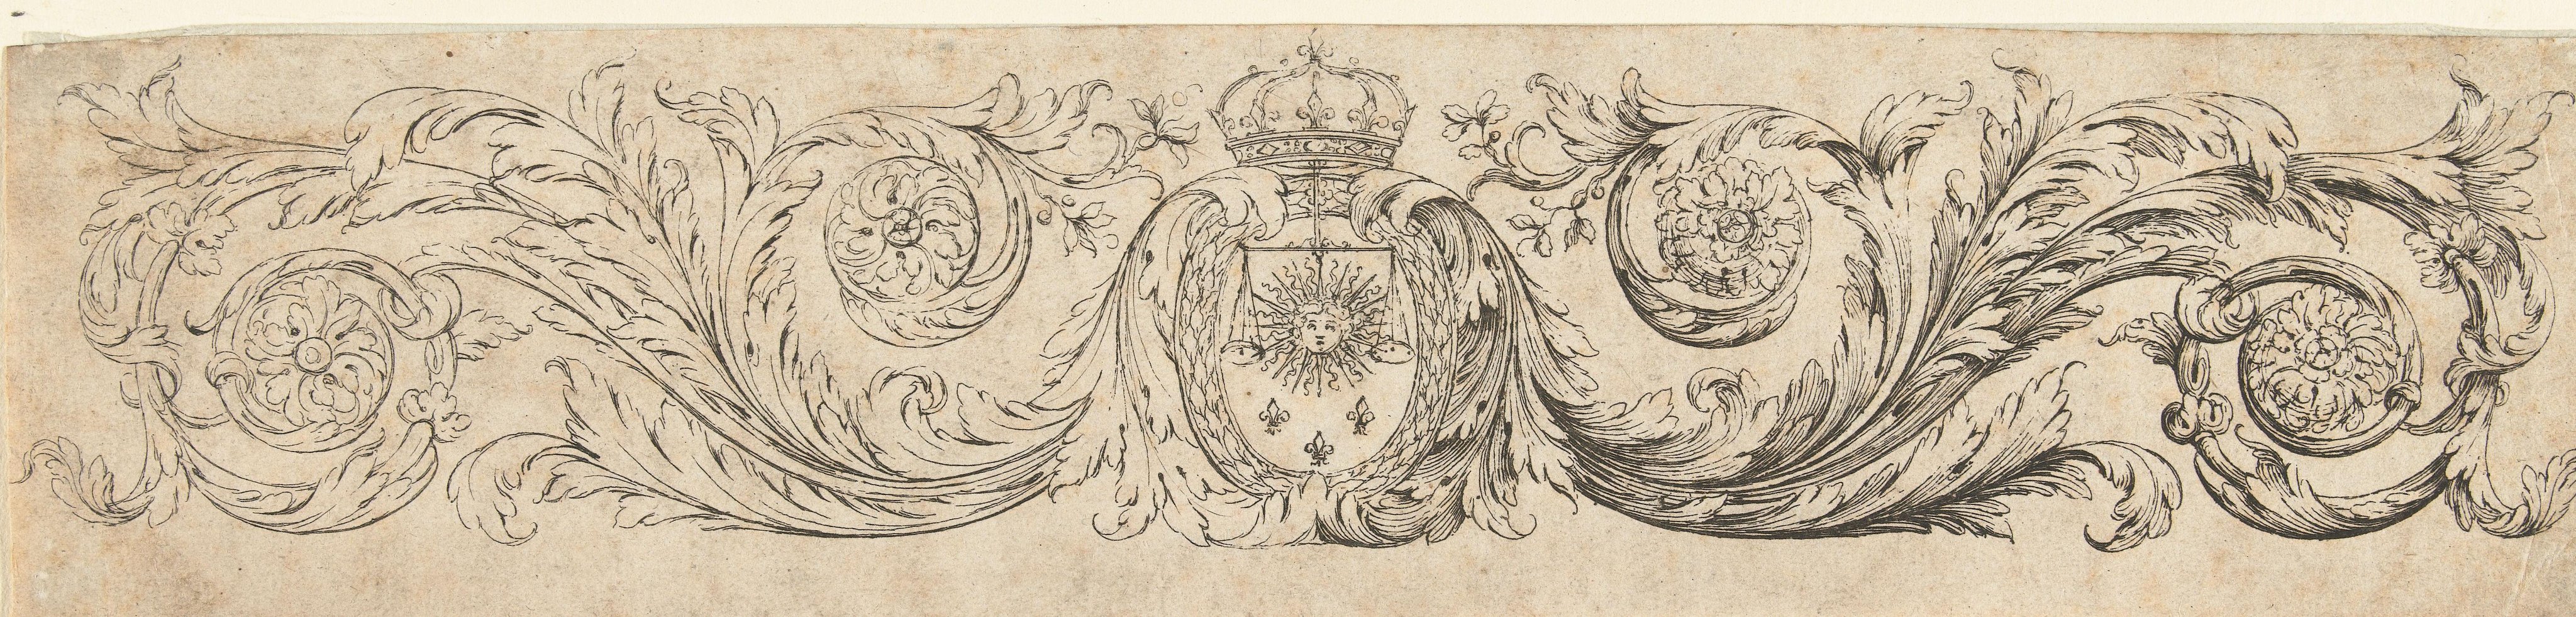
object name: print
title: Twee bladranken met rozetten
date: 1670-1693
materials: paper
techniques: etching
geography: france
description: In het midden een wapenschild met een stralende zon (symbool van Louis XIV), daarboven een Franse koningskroon.